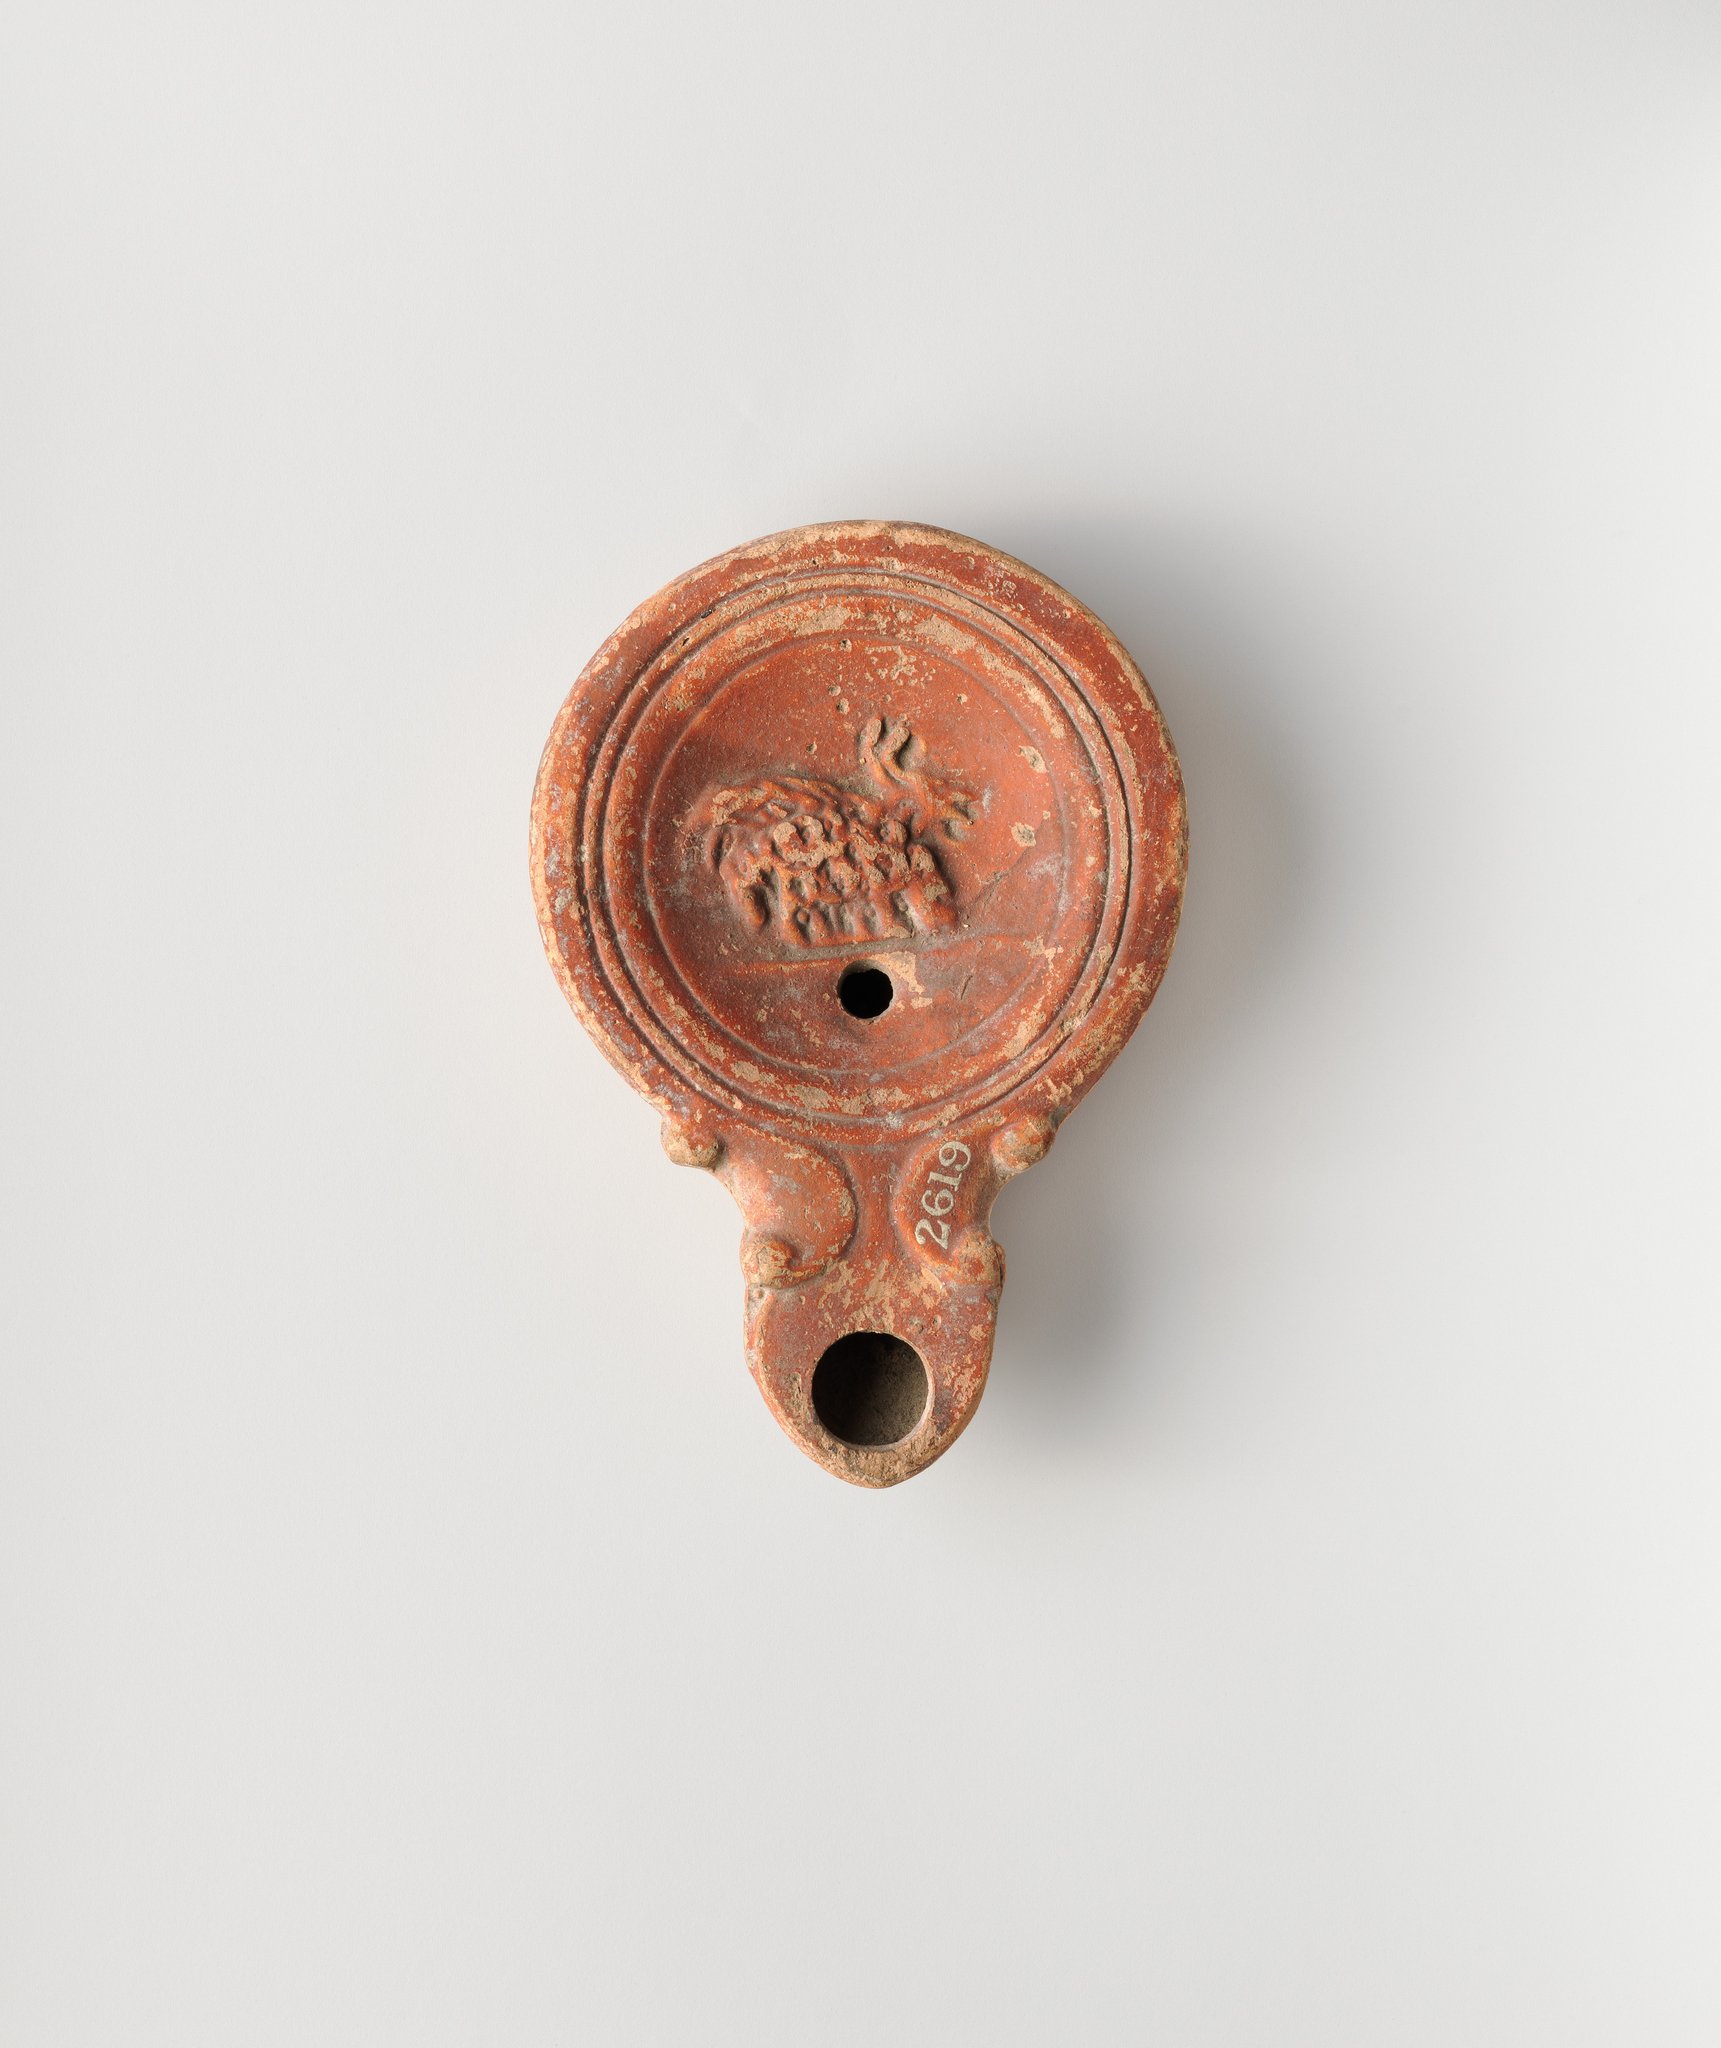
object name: lamp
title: Terracotta oil lamp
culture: roman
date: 100 BCE-100 CE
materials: terracotta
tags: animals